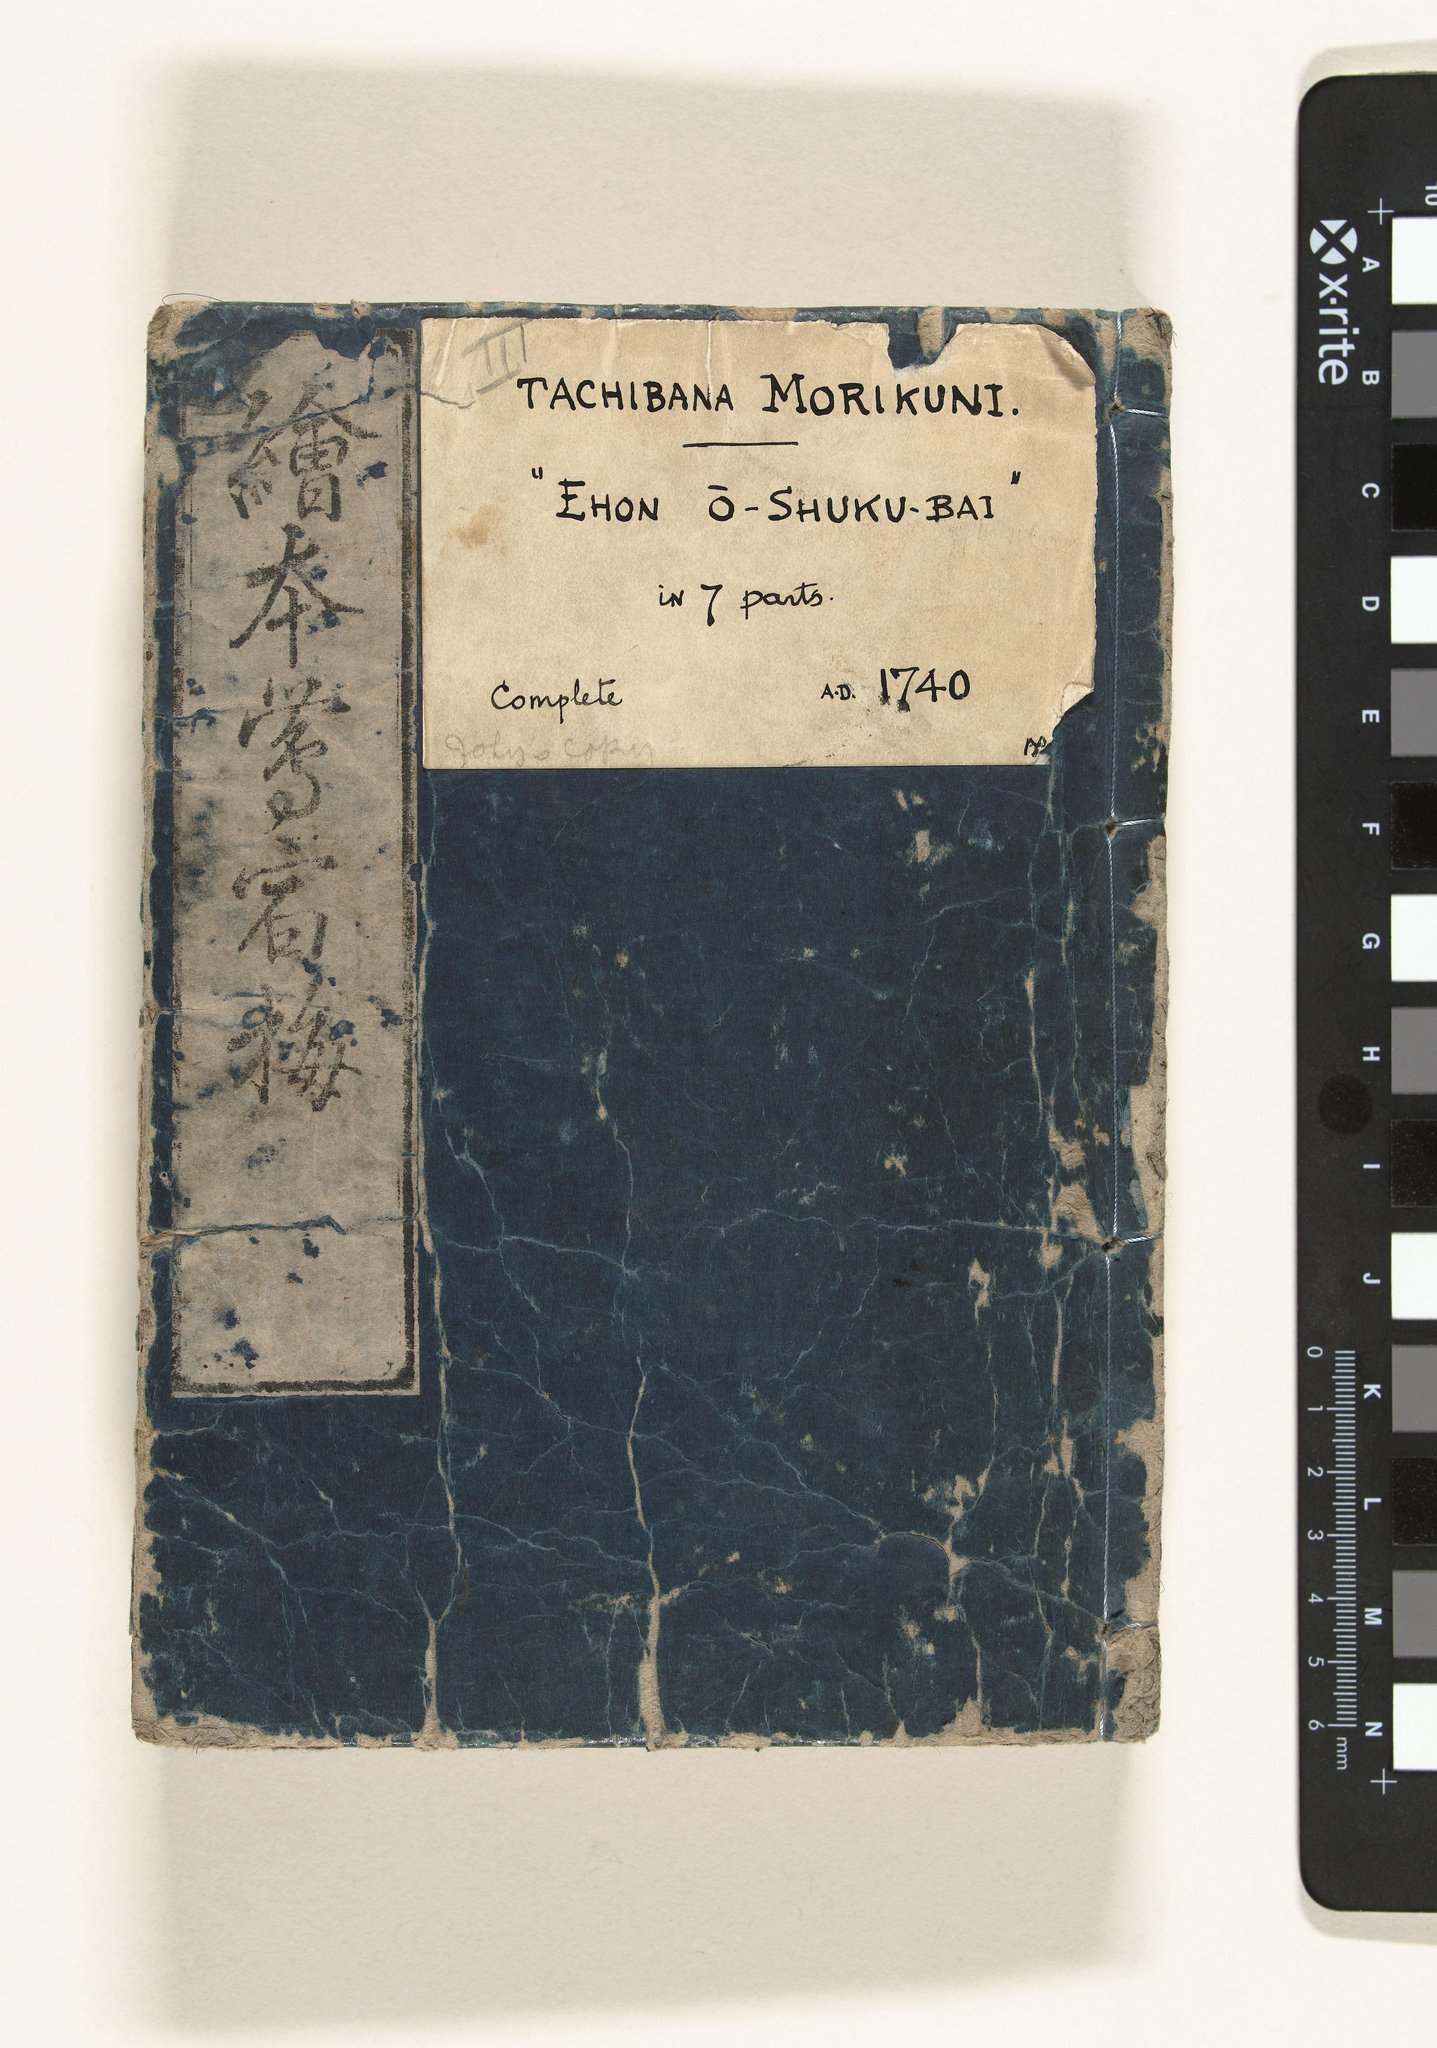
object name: book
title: Geïllustreerd boek over bloemen, dichters en vogels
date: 1740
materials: paper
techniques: woodcut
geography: osaka